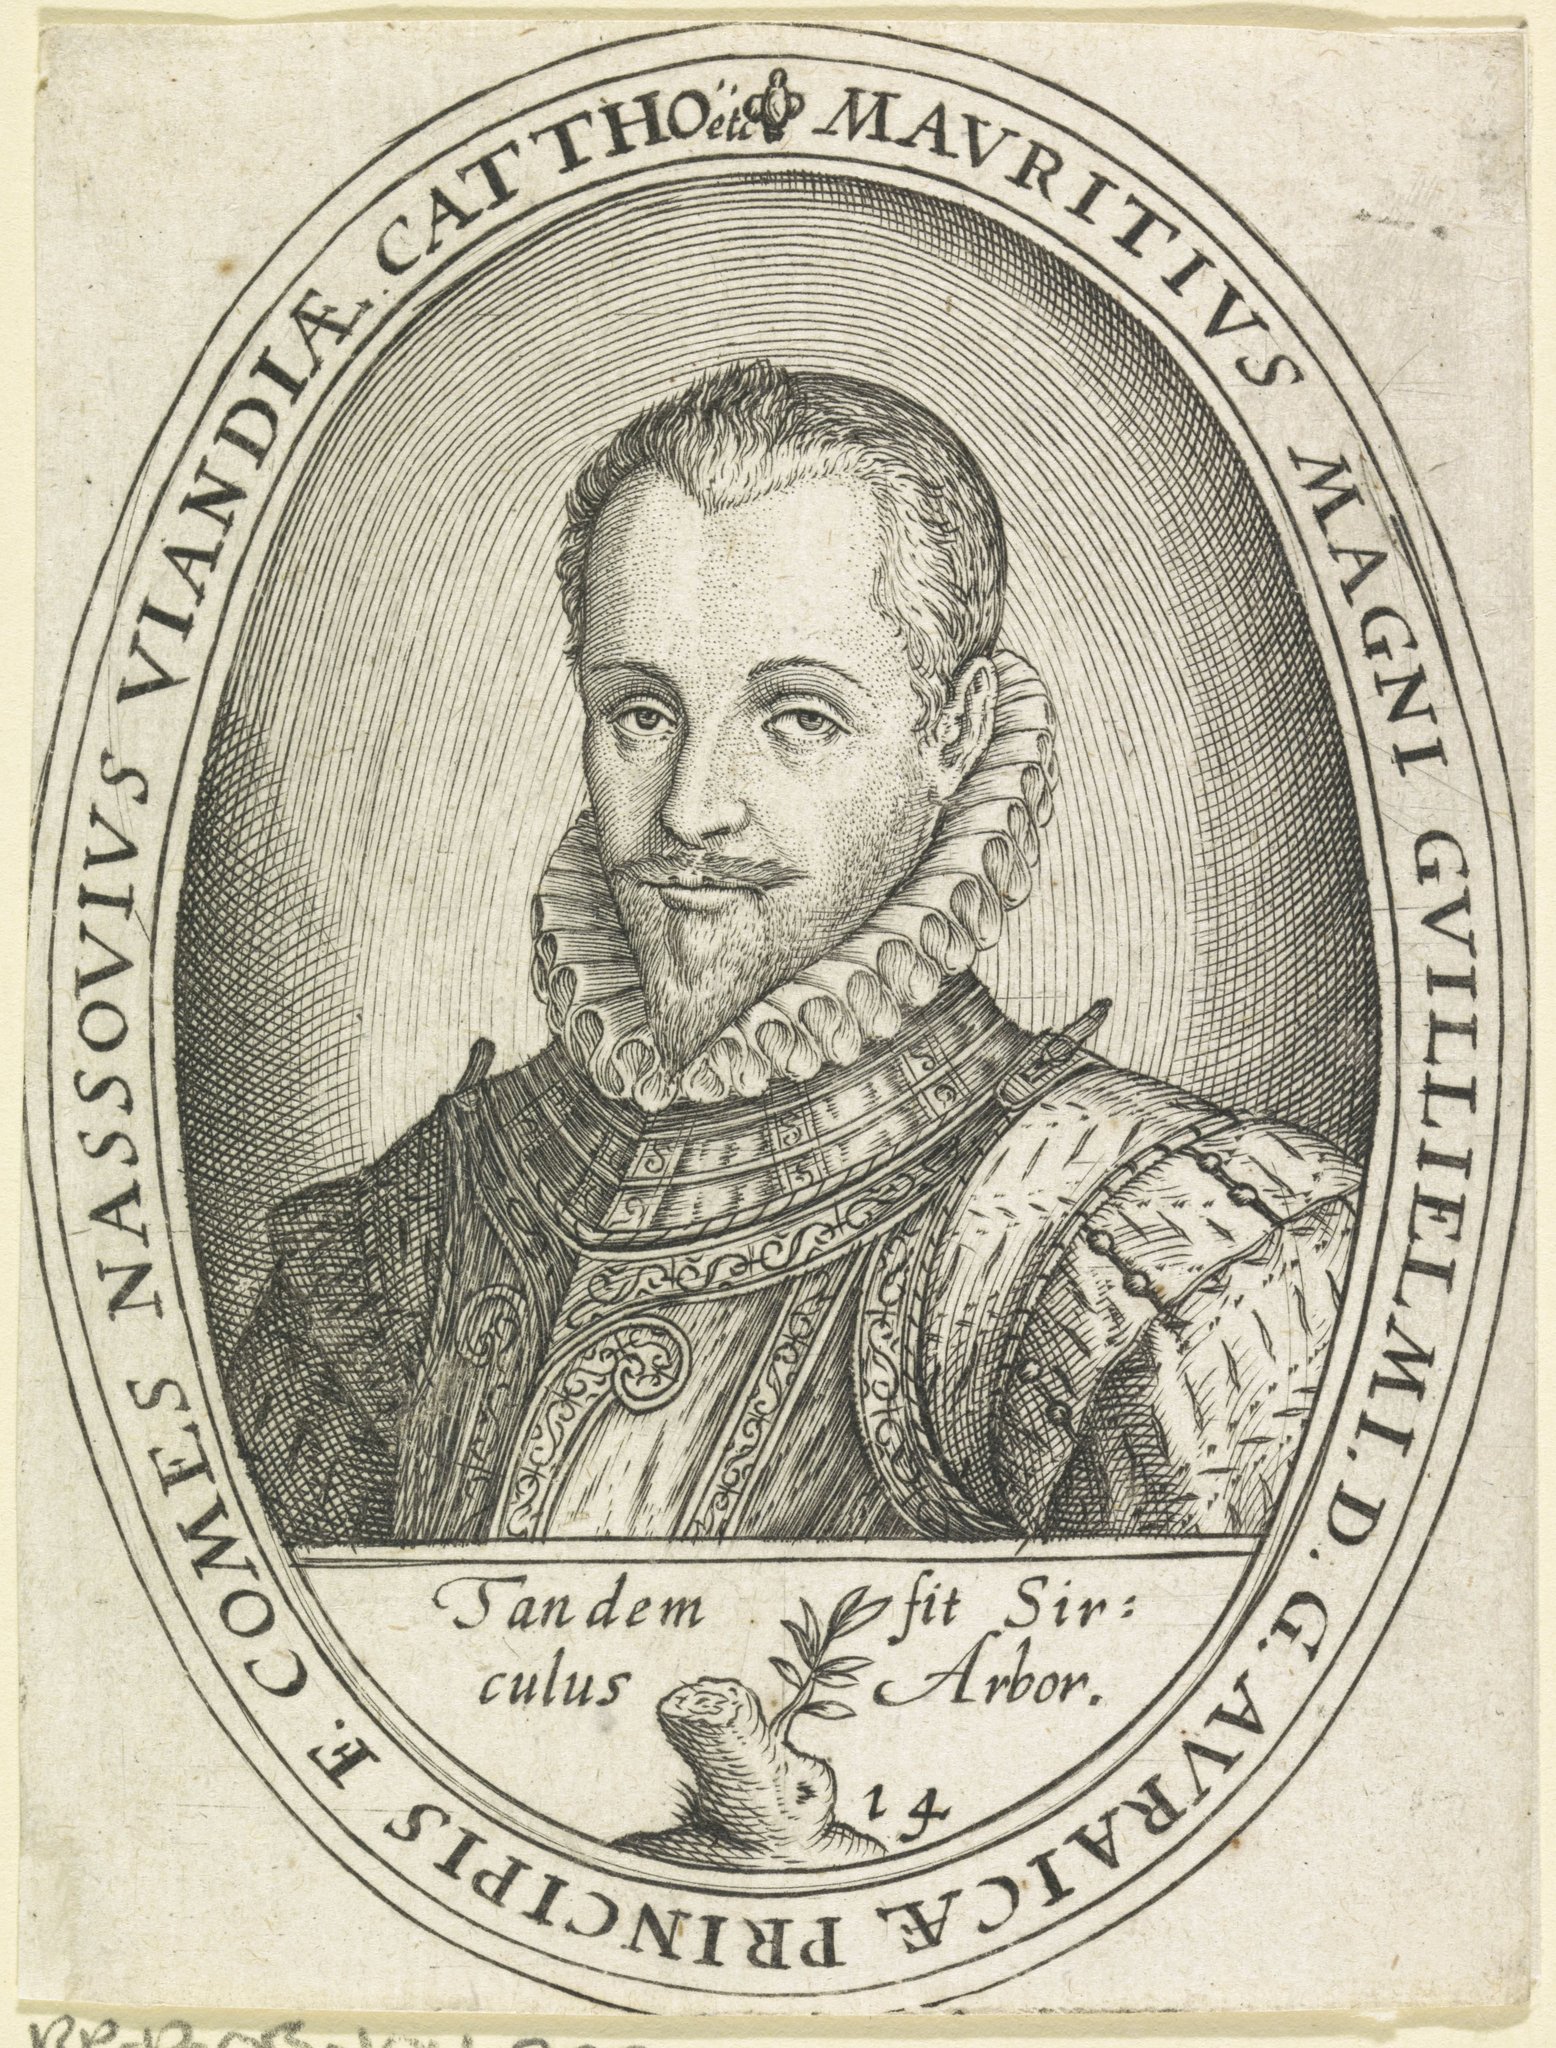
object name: print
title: Portret van Maurits, prins van Oranje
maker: Anonymous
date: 1600-1699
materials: paper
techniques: engraving, etching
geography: low countries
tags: maurice (prince of orange)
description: De hier vermelde titel verwijst naar de hoogst verkregen titel van de geportretteerde, niet per se naar de titel die de geportretteerde op deze voorstelling draagt.